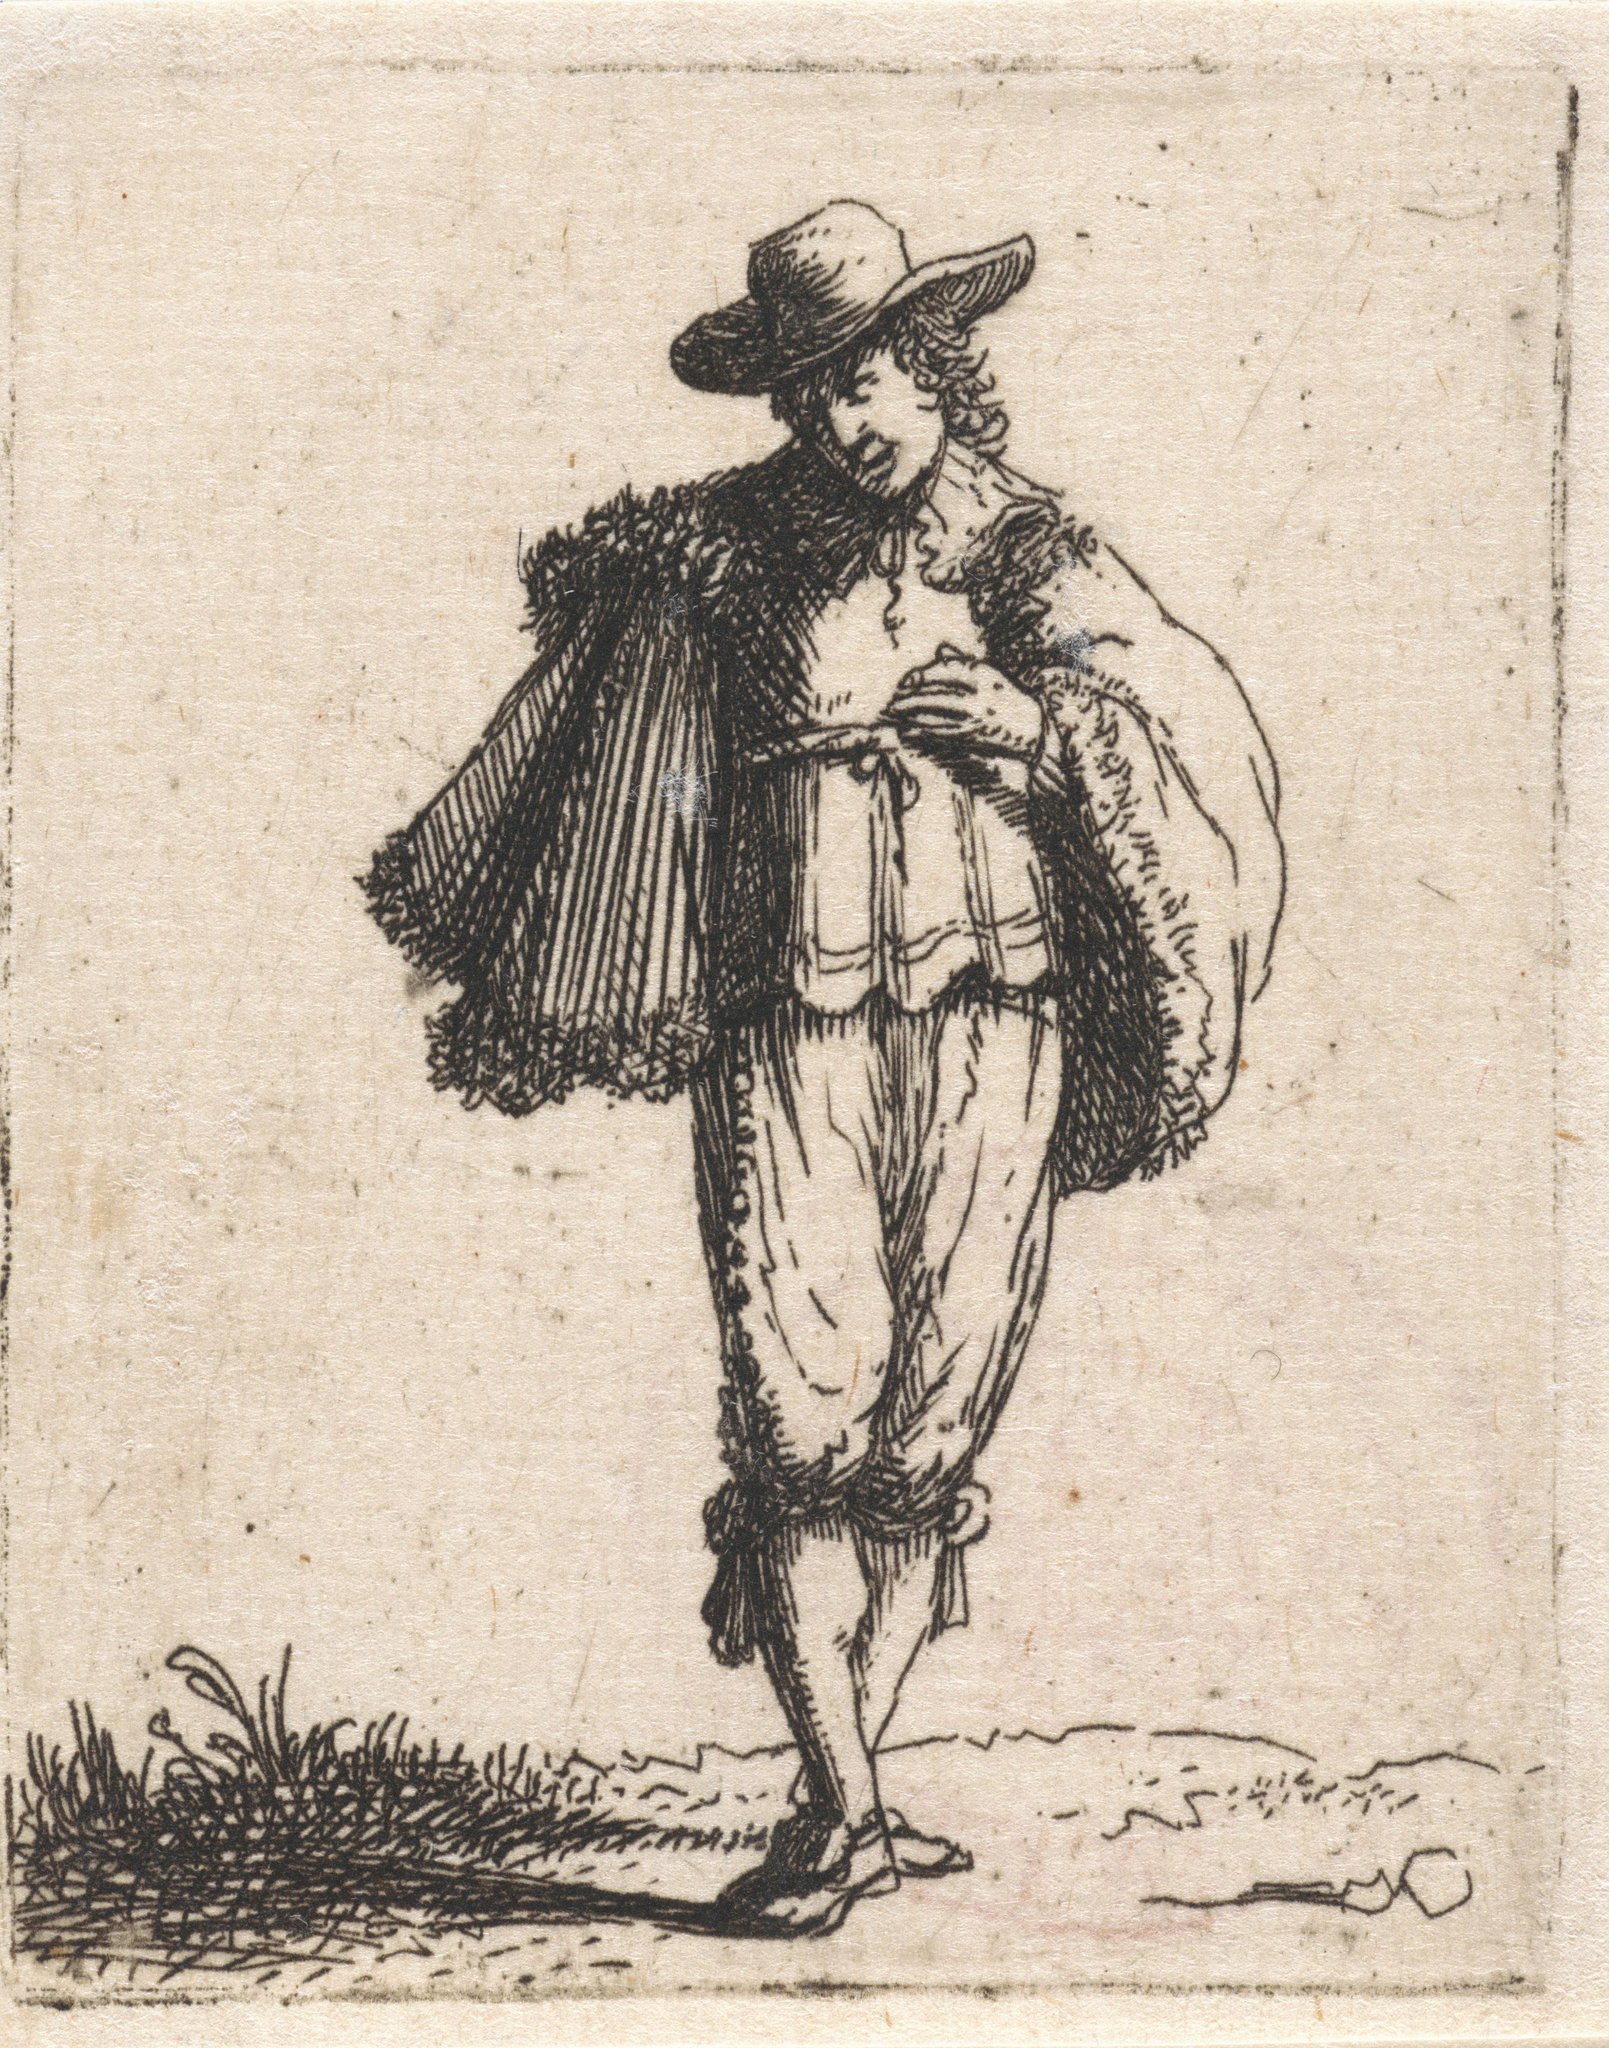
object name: print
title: Man met cape en hoed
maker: jan gillisz. van vliet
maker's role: draughtsman, painter, print maker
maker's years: 1600-1668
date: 1632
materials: paper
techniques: etching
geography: leiden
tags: cape (+ men's clothes), cape (+ fur used for clothes), head-gear: hat (+ men's clothes)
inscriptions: collector's mark: Lugt 240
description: Een elegant geklede man draagt een met bont gevoerde korte mantel en op zijn hoofd een hoed met een rand.